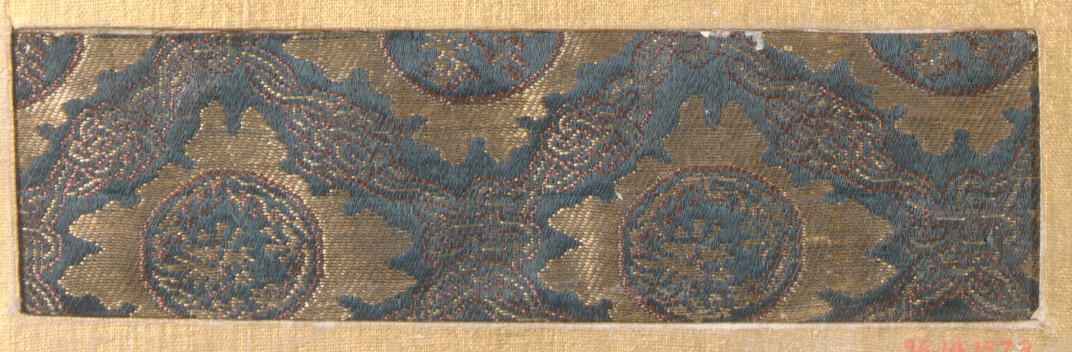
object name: piece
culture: japanese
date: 1701-1900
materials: silk